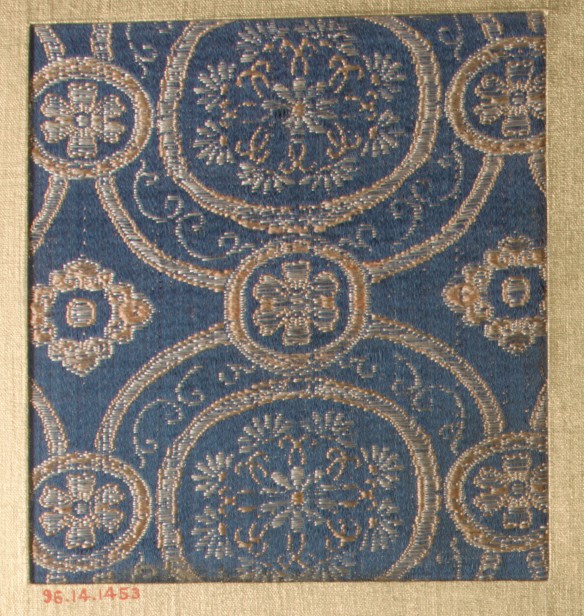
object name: piece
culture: japanese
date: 1701-1900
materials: silk